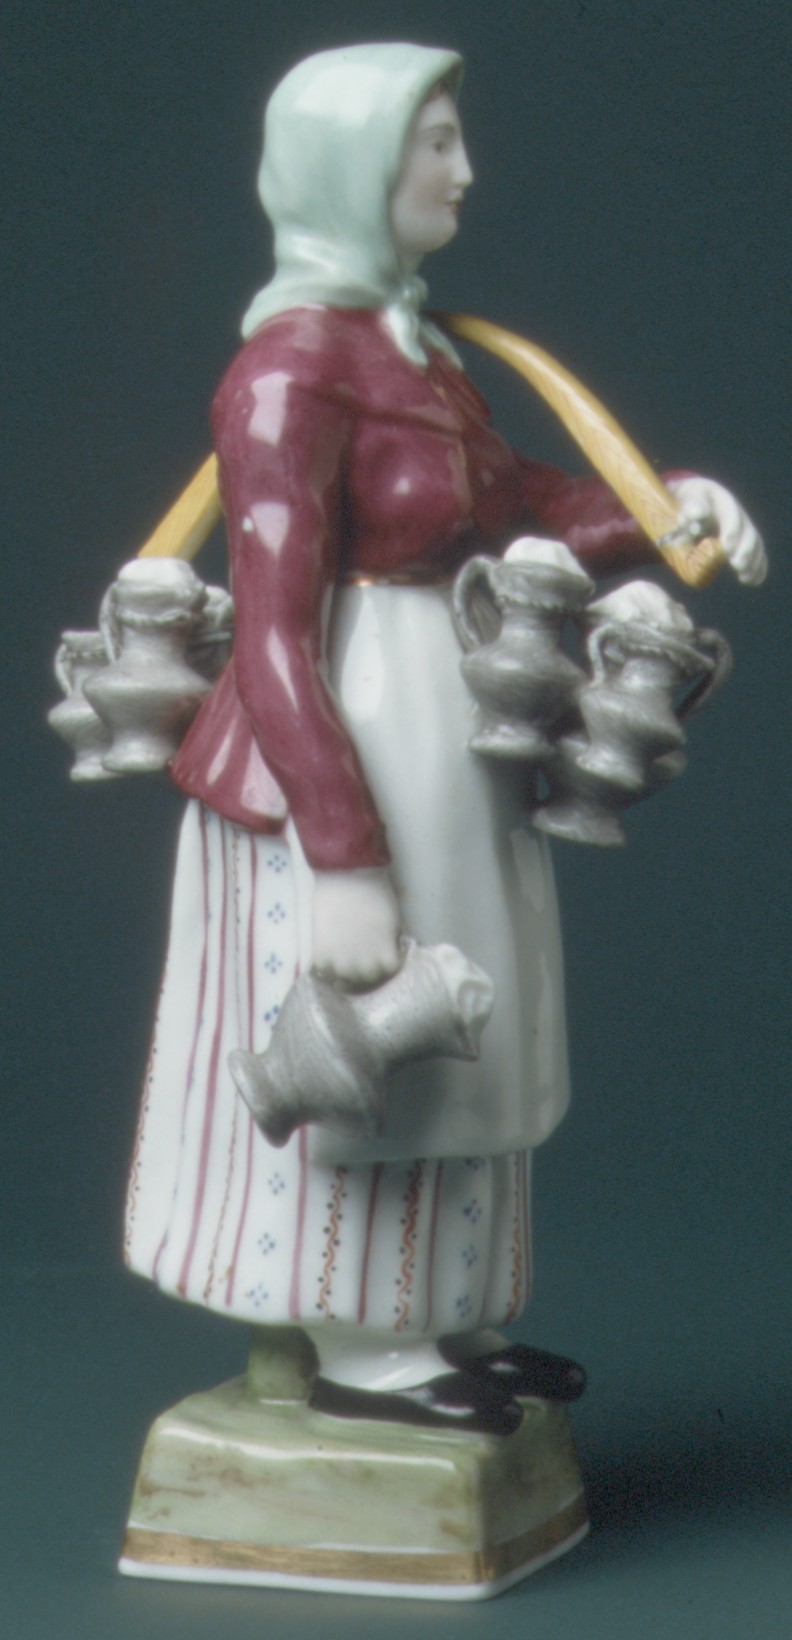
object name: figure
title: Milkmaid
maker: gardner manufactory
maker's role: manufactory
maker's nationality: russian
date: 1820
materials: hard paste porcelain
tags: women